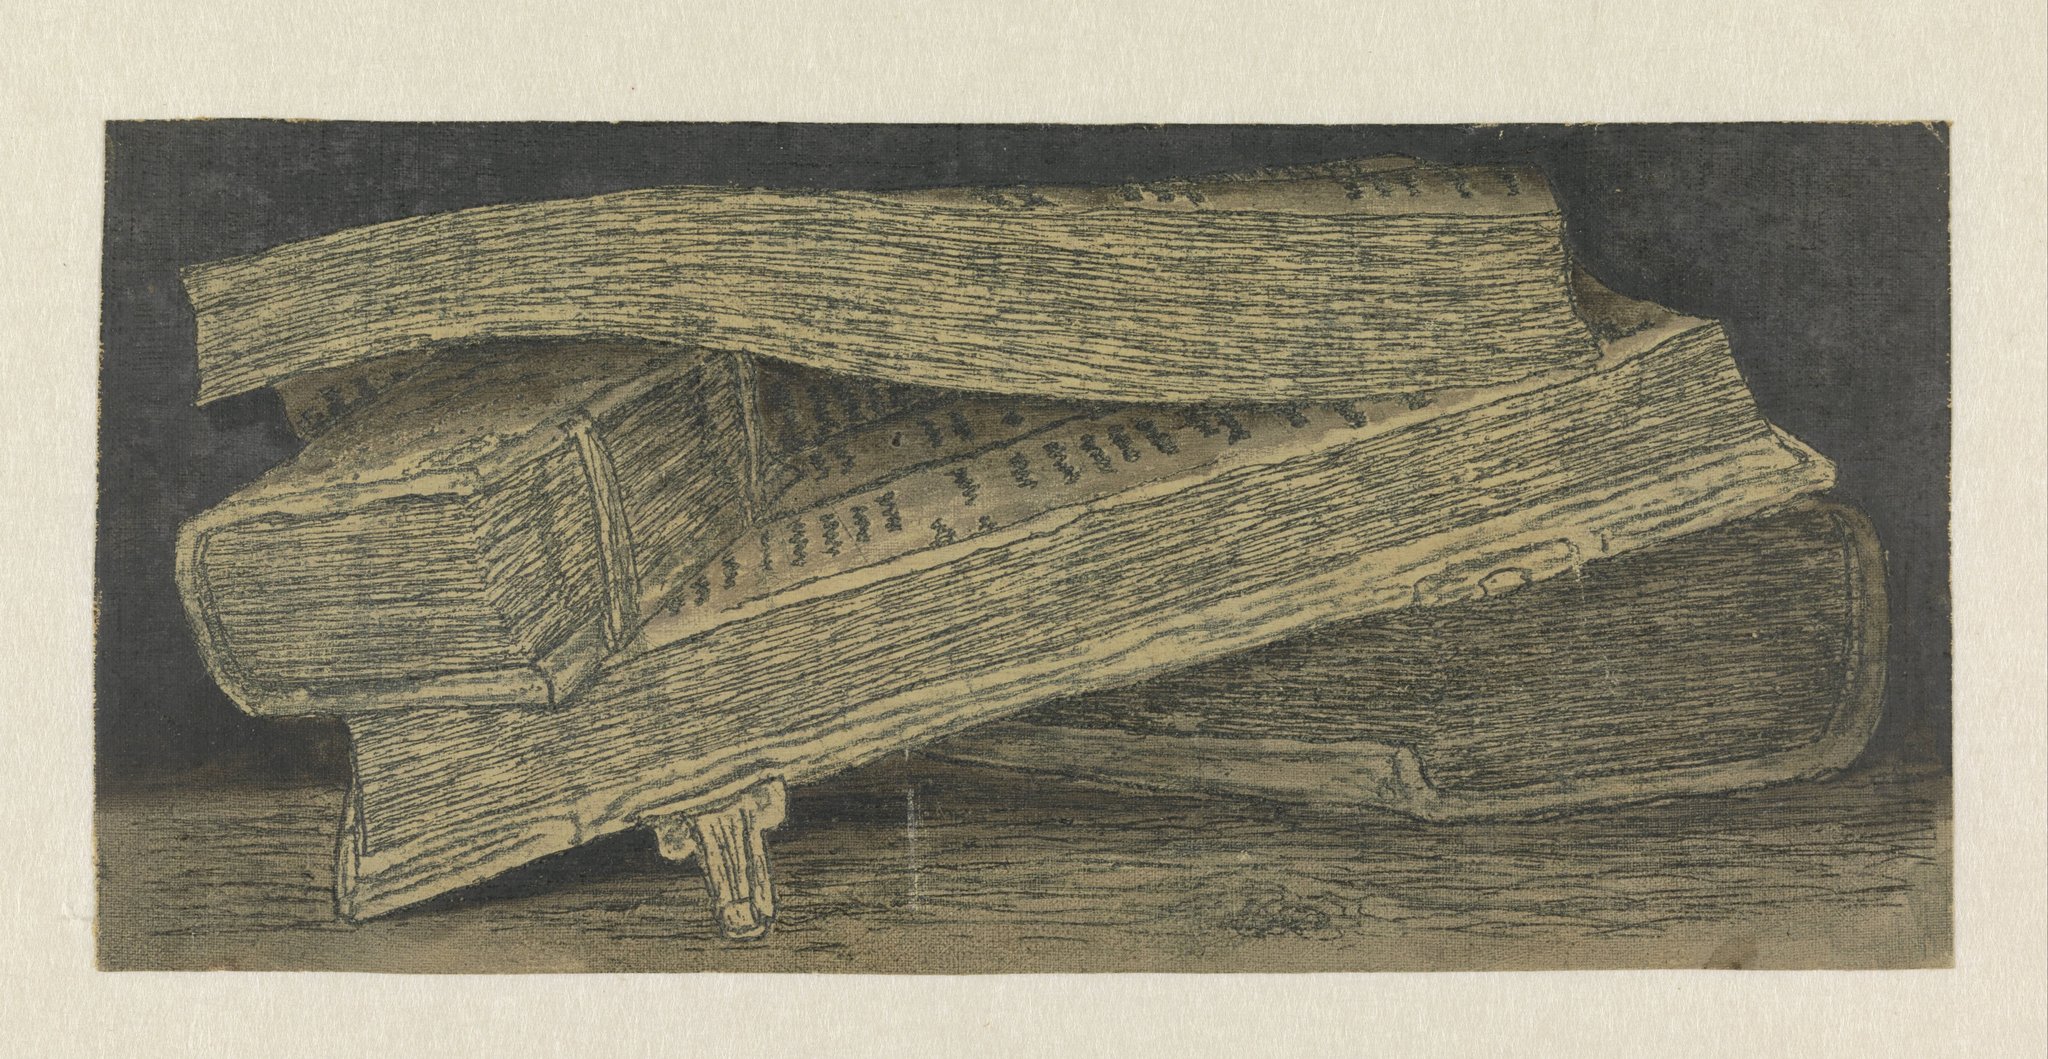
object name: print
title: Still Life with Books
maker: hercules segers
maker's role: draughtsman, painter, print maker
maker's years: 1589-1640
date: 1618-1622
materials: cotton, paint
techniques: etching, hand coloring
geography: amsterdam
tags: still life of related objects, book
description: While Segers’ stack of books looks unassuming enough, it is entirely original, and may even be the earliest still life in European graphic art. While still lifes frequently feature in 17th-century paintings, they are rarely found in black-and-white (in prints).